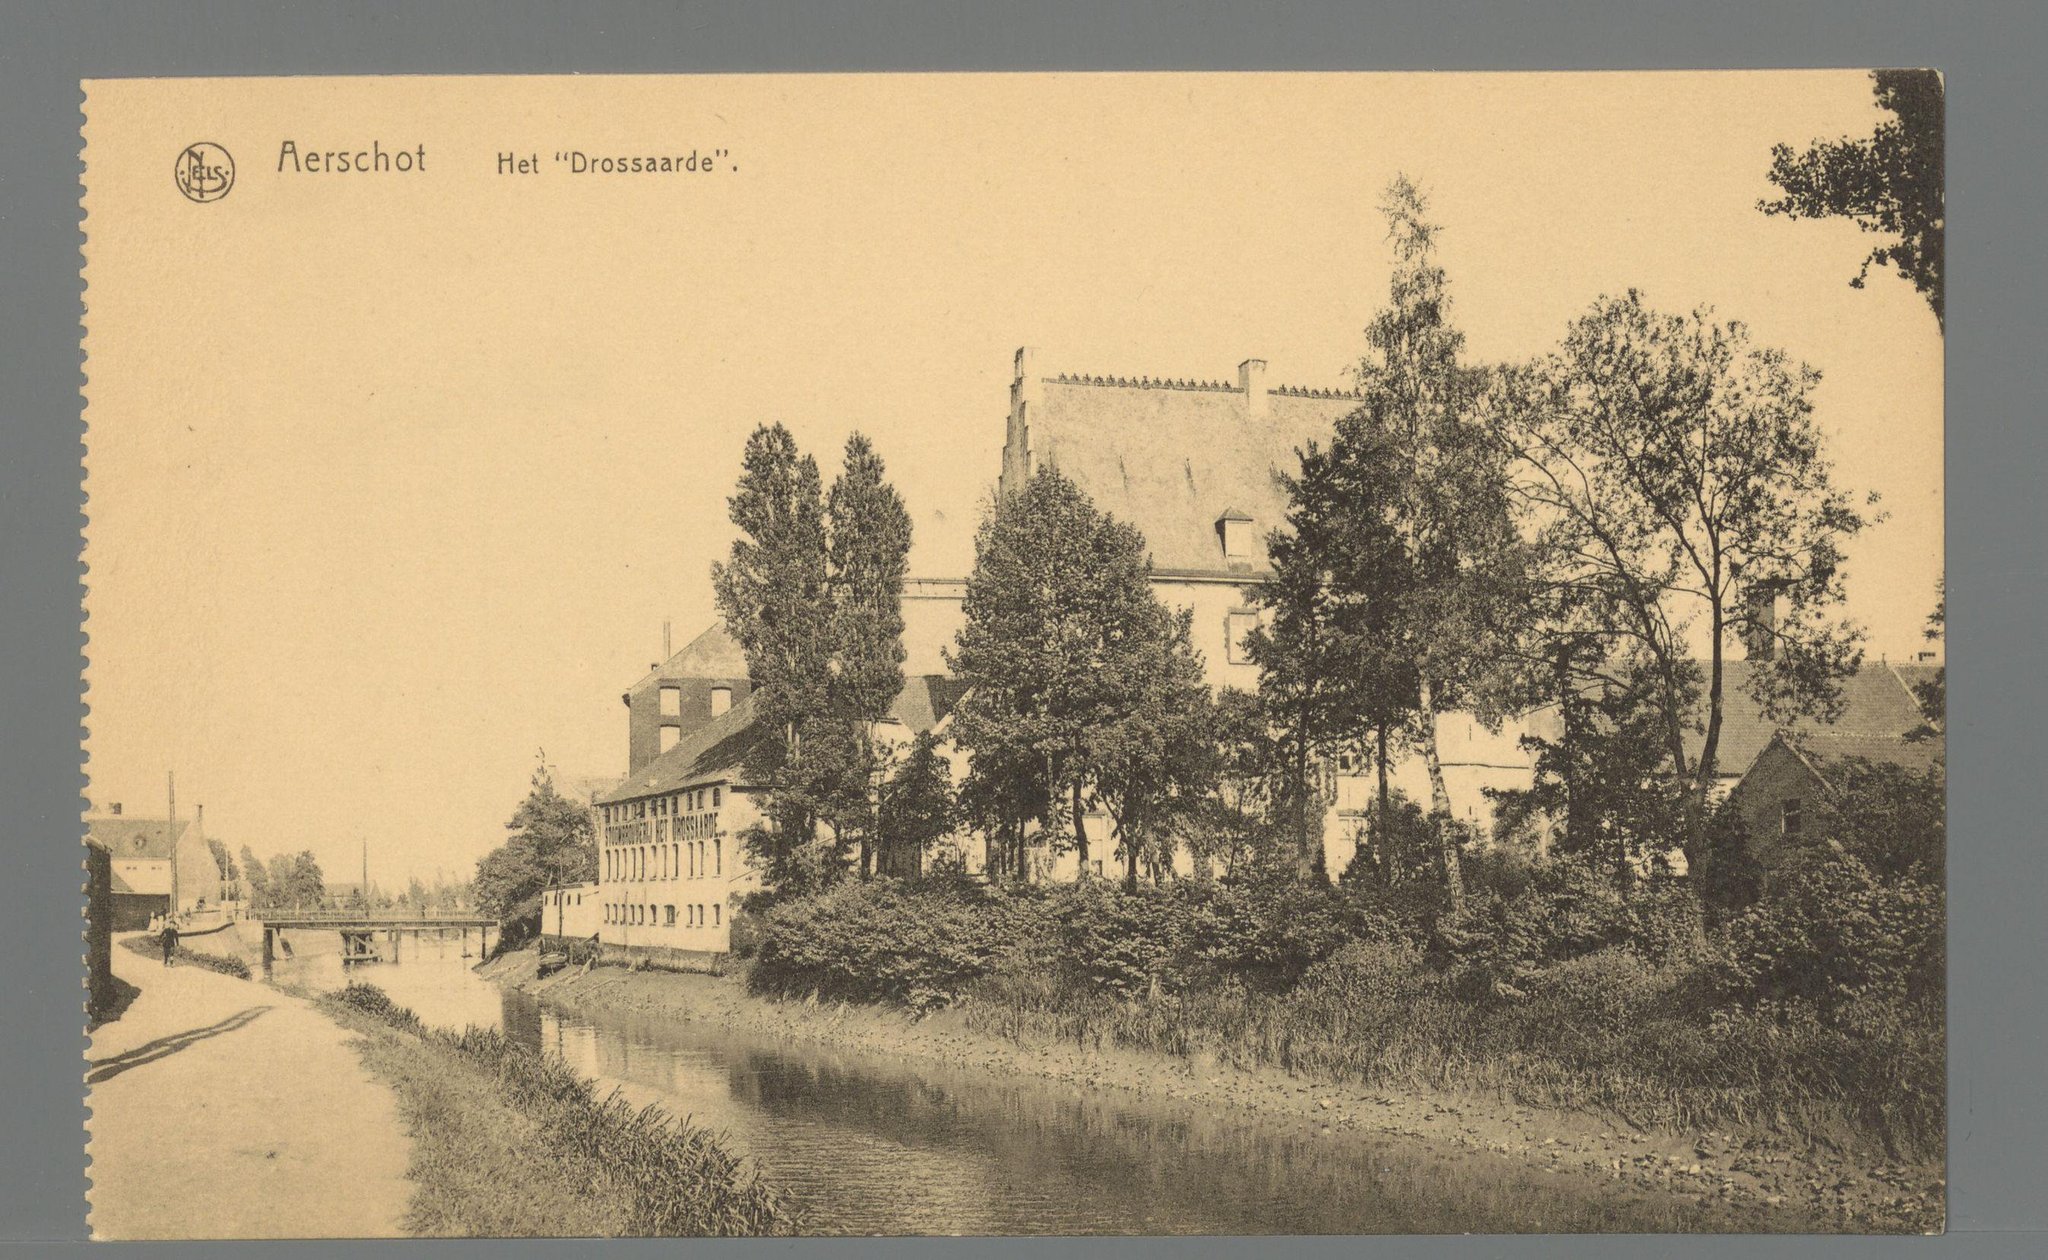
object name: photomechanical print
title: Aerschot. Het "Drossaarde"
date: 1913-1930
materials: cardboard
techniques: photograph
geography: aarschot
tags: canal, rural housing, e.g. country-house, villa, cottage